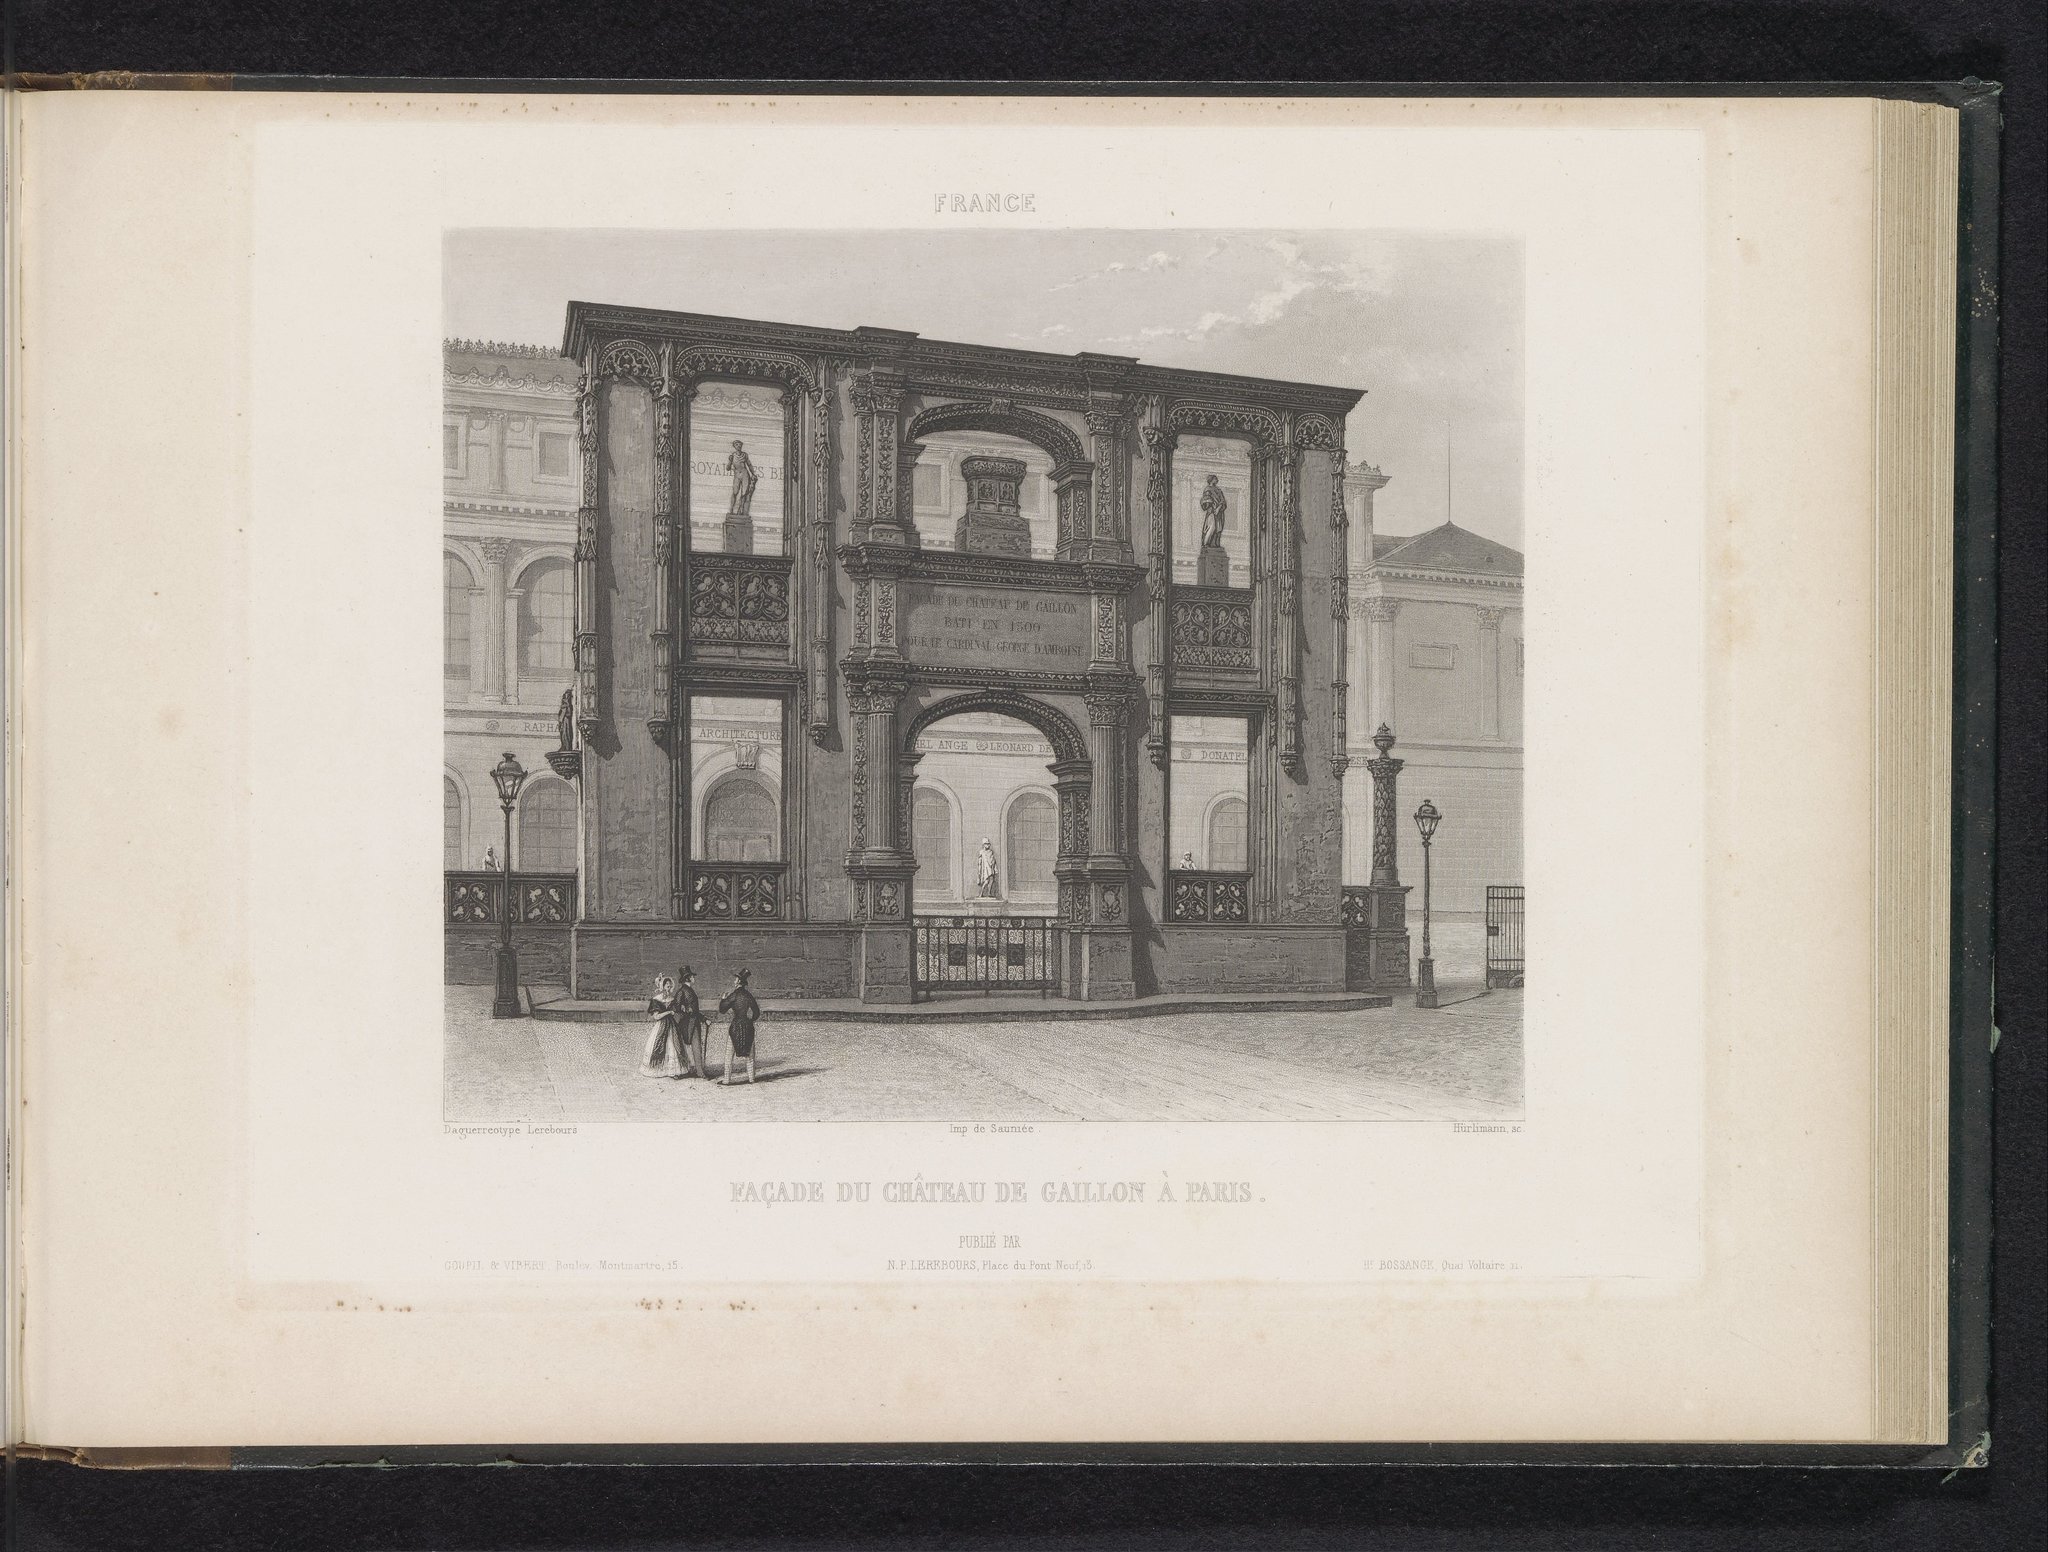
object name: page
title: Façade du Château de Gaillon à Paris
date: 1839-1841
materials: paper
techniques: aquatint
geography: paris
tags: sculpture, façade (of house or building)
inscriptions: inscription: ‘Rittner & Goupil Boulevd Montmartre 15’, inscription: ‘Hr. Bossance Quai Voltaire 11’, inscription: ‘N.P. Lerebours Place du Pont Neuf 15’